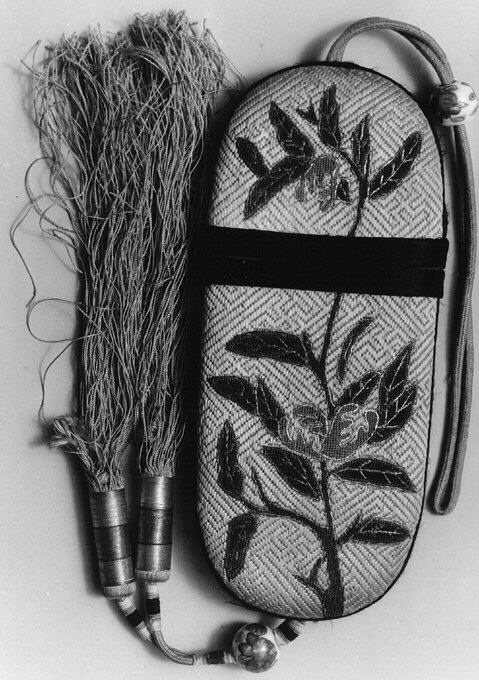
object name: eyeglass case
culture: chinese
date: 1701-1900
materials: metal thread, silk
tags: flowers